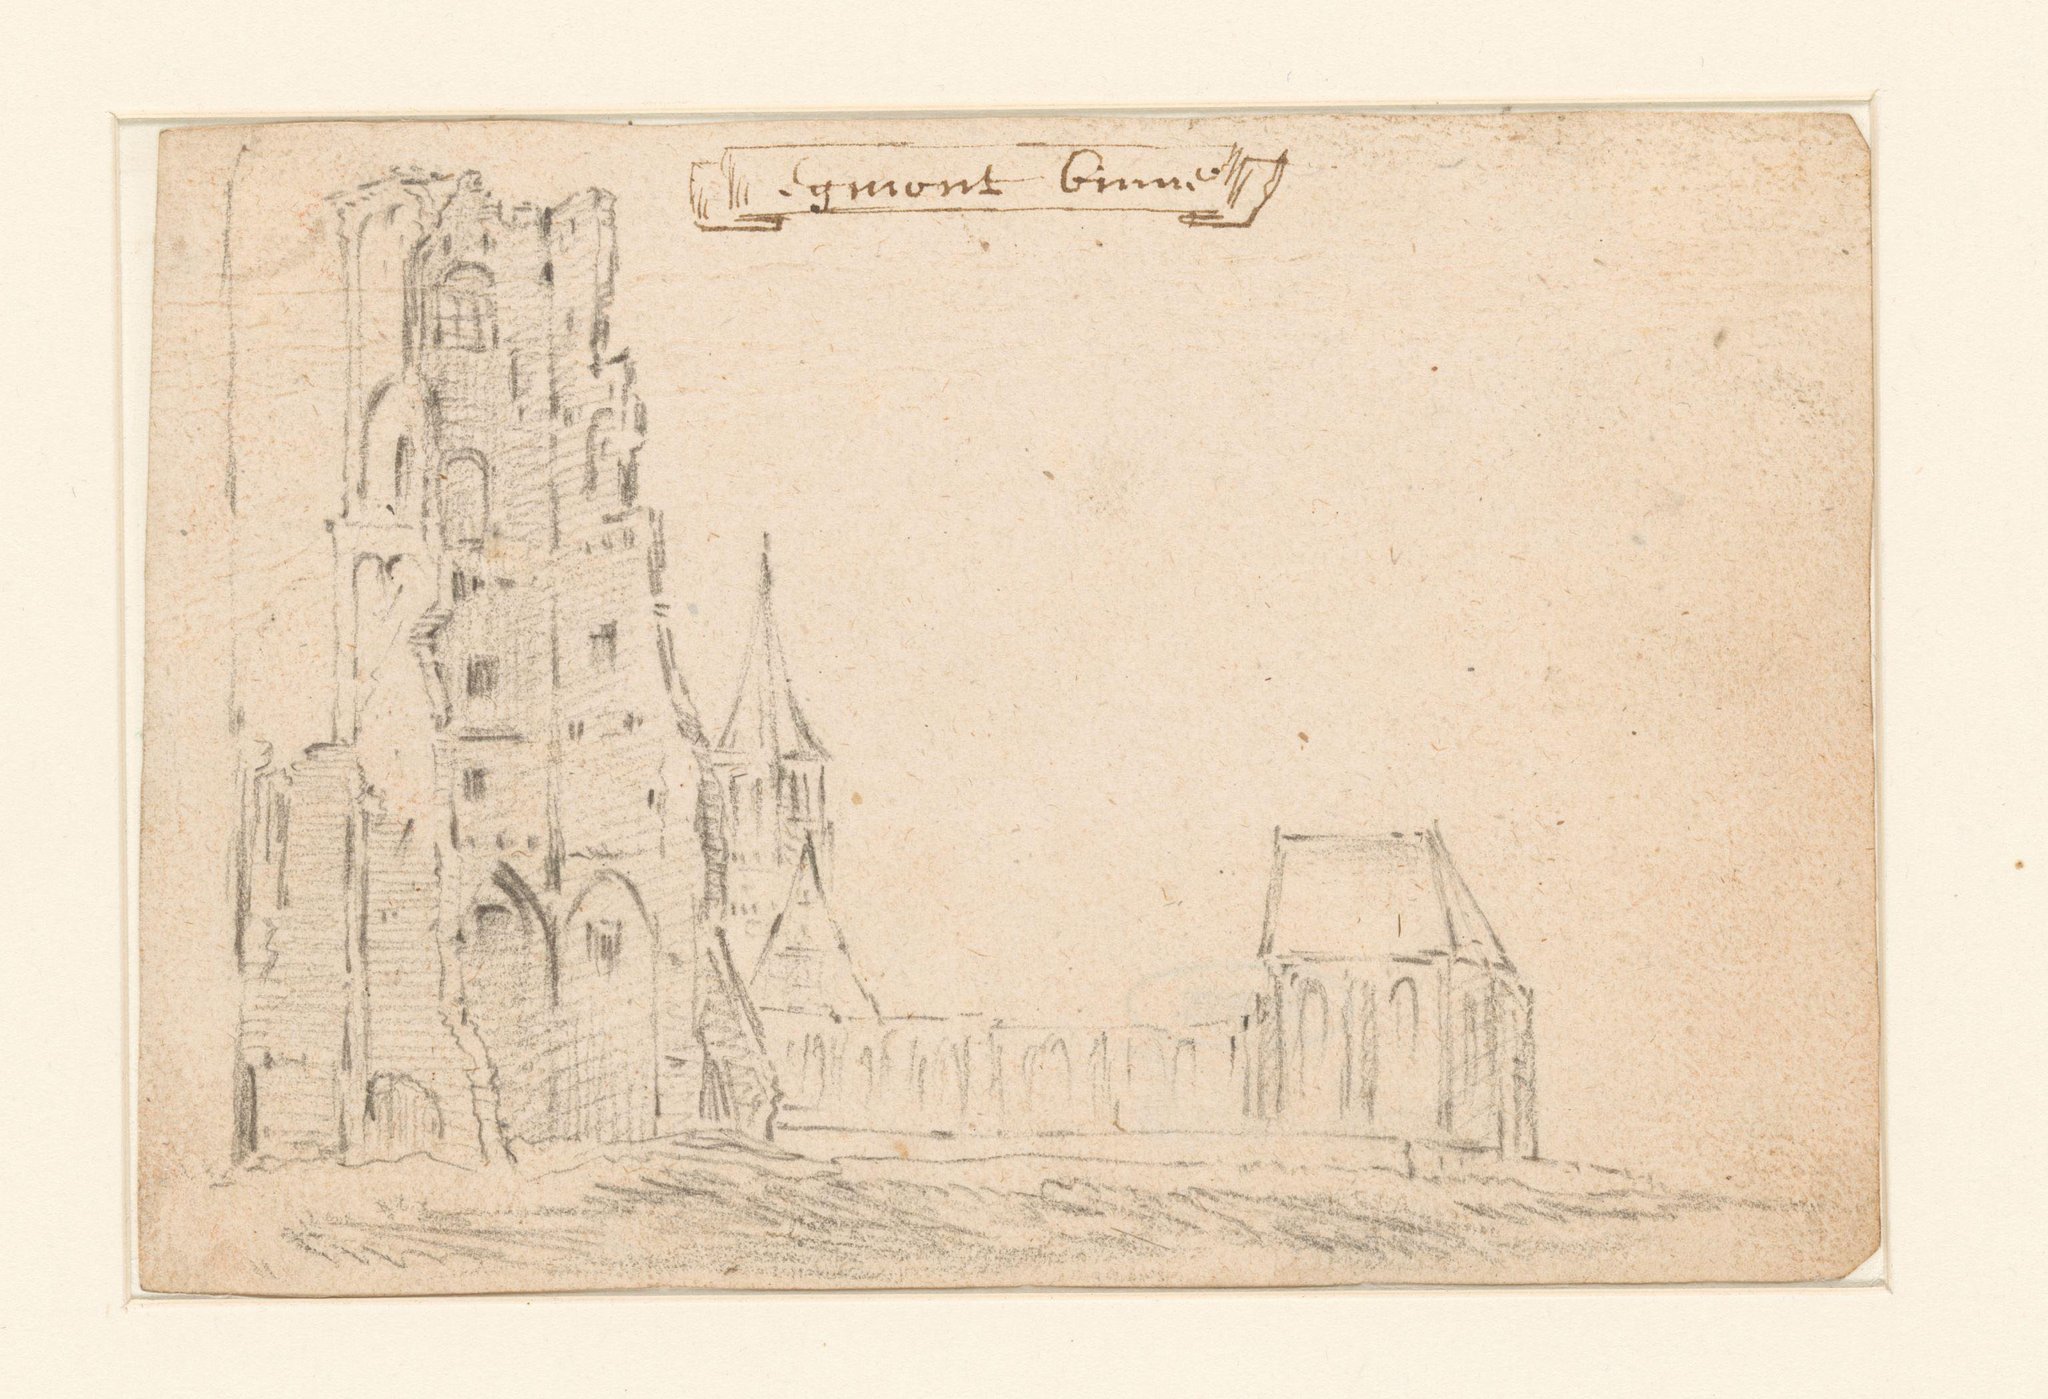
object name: drawing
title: Ruïne van de abdij van Egmond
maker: salomon van ruysdael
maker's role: draughtsman, painter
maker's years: 1600-1670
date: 1630-1670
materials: ink, paper, pencil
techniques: pen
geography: egmond-binnen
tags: ruin of church, monastery, etc.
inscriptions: inscription: ‘Egmont binnen’, collector's mark: Lugt 2228